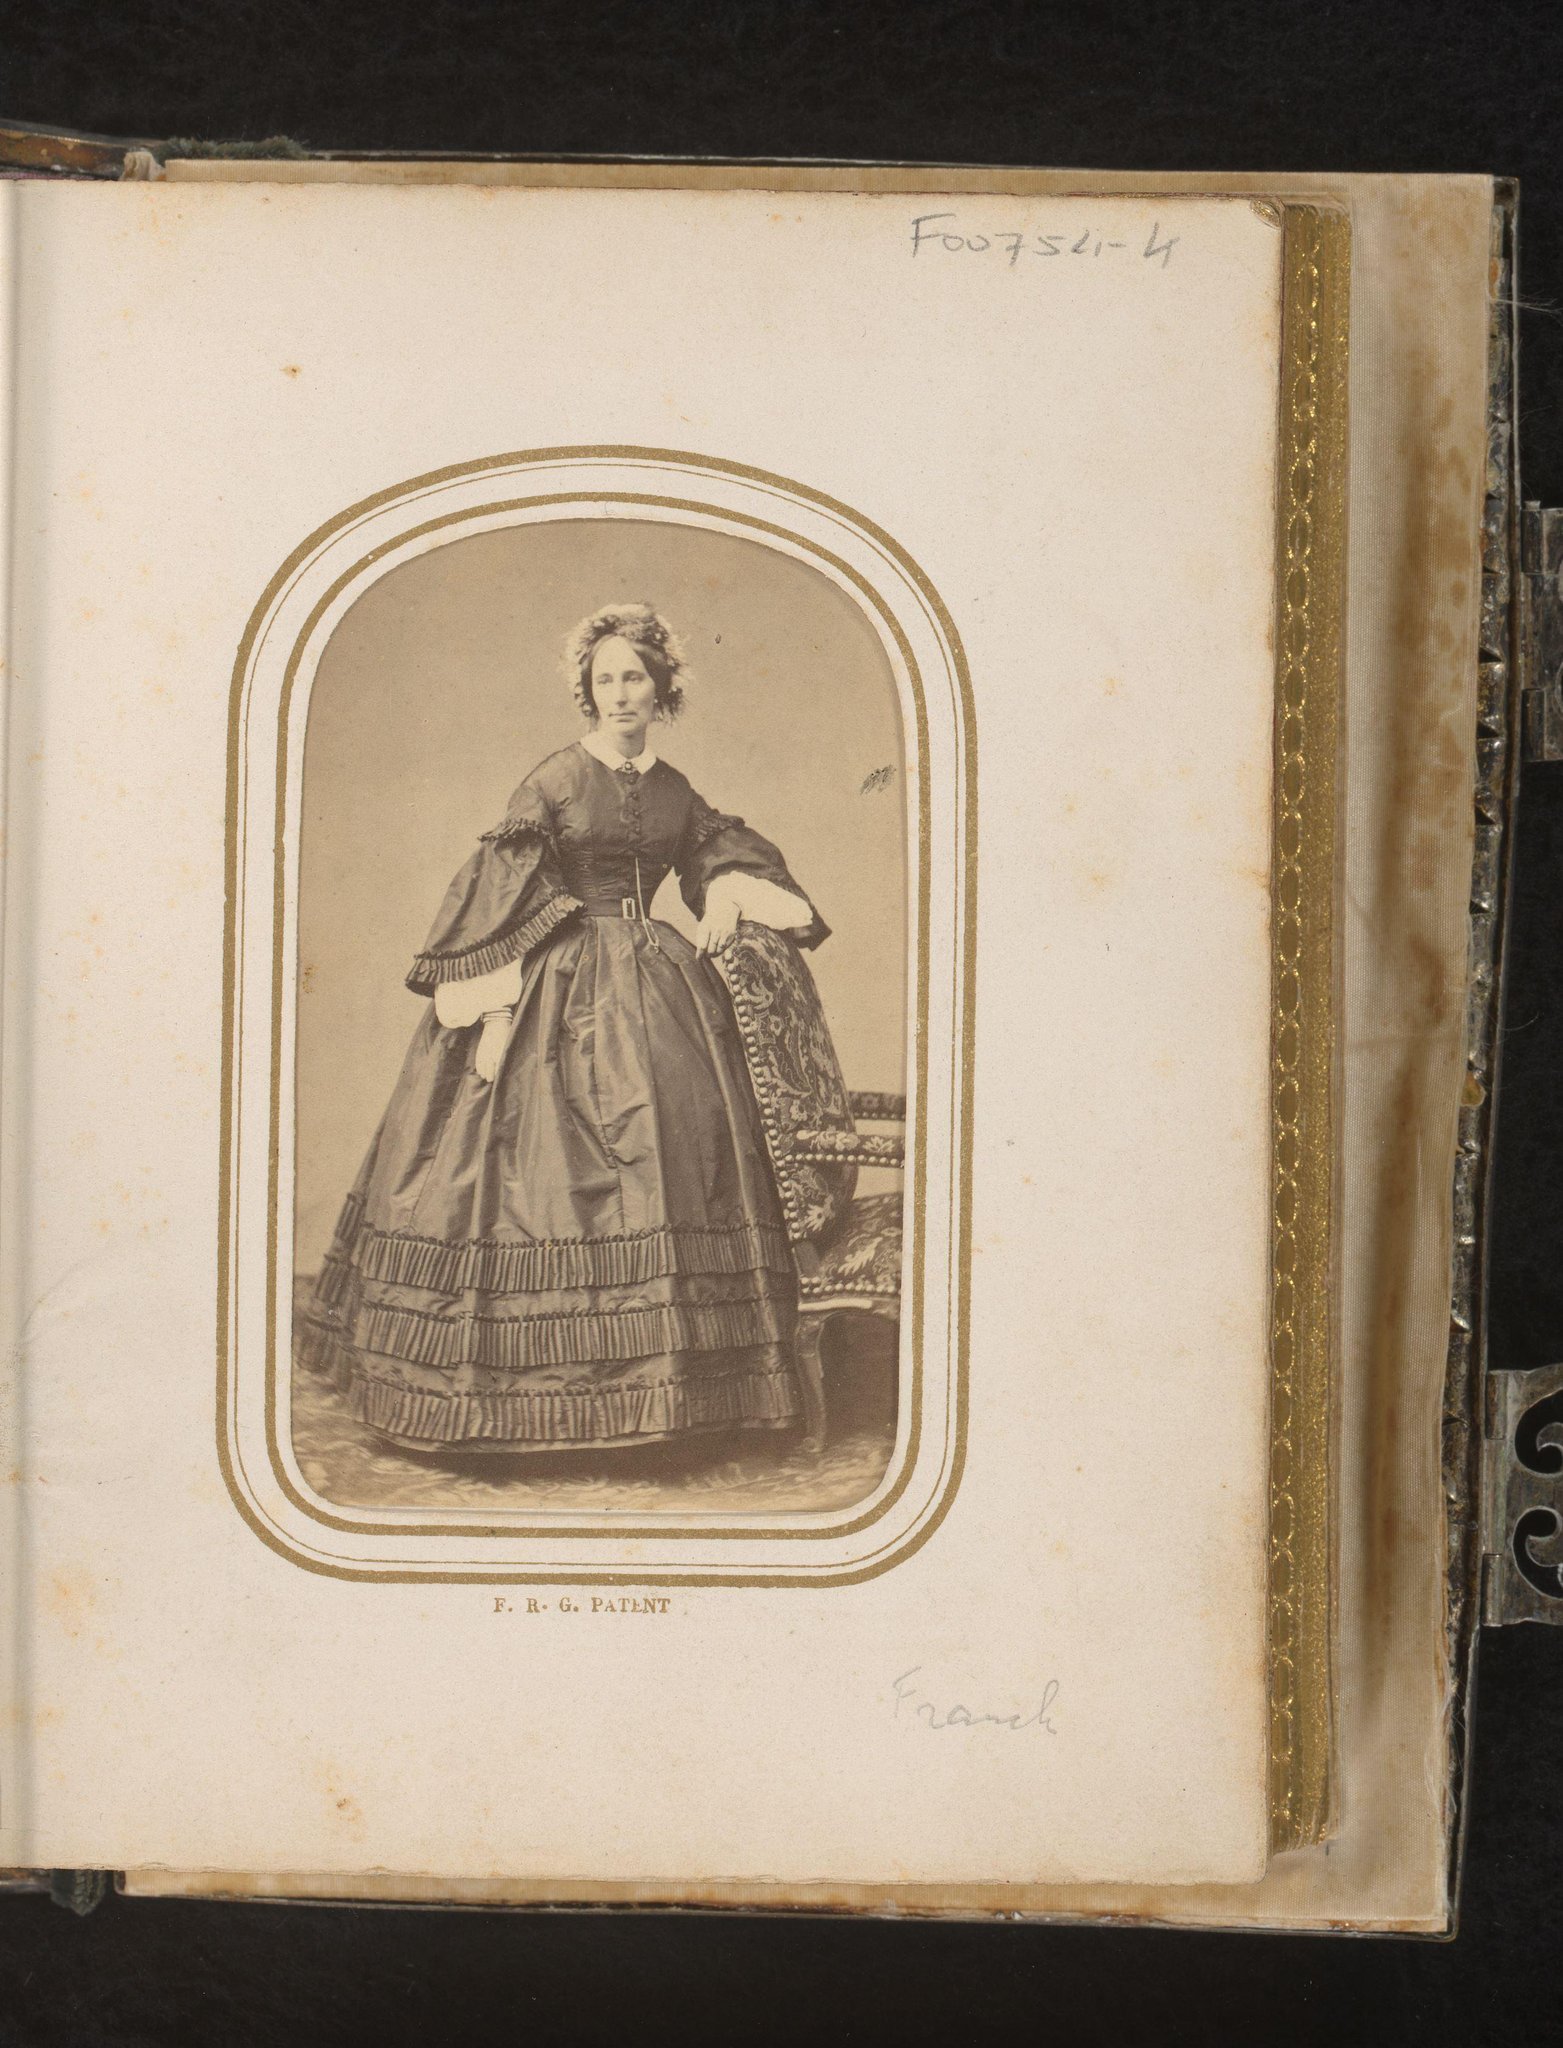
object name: carte de visite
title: Portret van een vrouw met muts bij een stoel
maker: françois marie louis franck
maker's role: fotograaf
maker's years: 1816-1906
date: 1855-1880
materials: cardboard, photographic support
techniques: albumen print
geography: france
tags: historical persons - bb - woman, head-gear: cap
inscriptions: annotation: ‘Franck’, inscription: ‘18 Rue Vivienne, succ.le 15 Place de la Bourse’